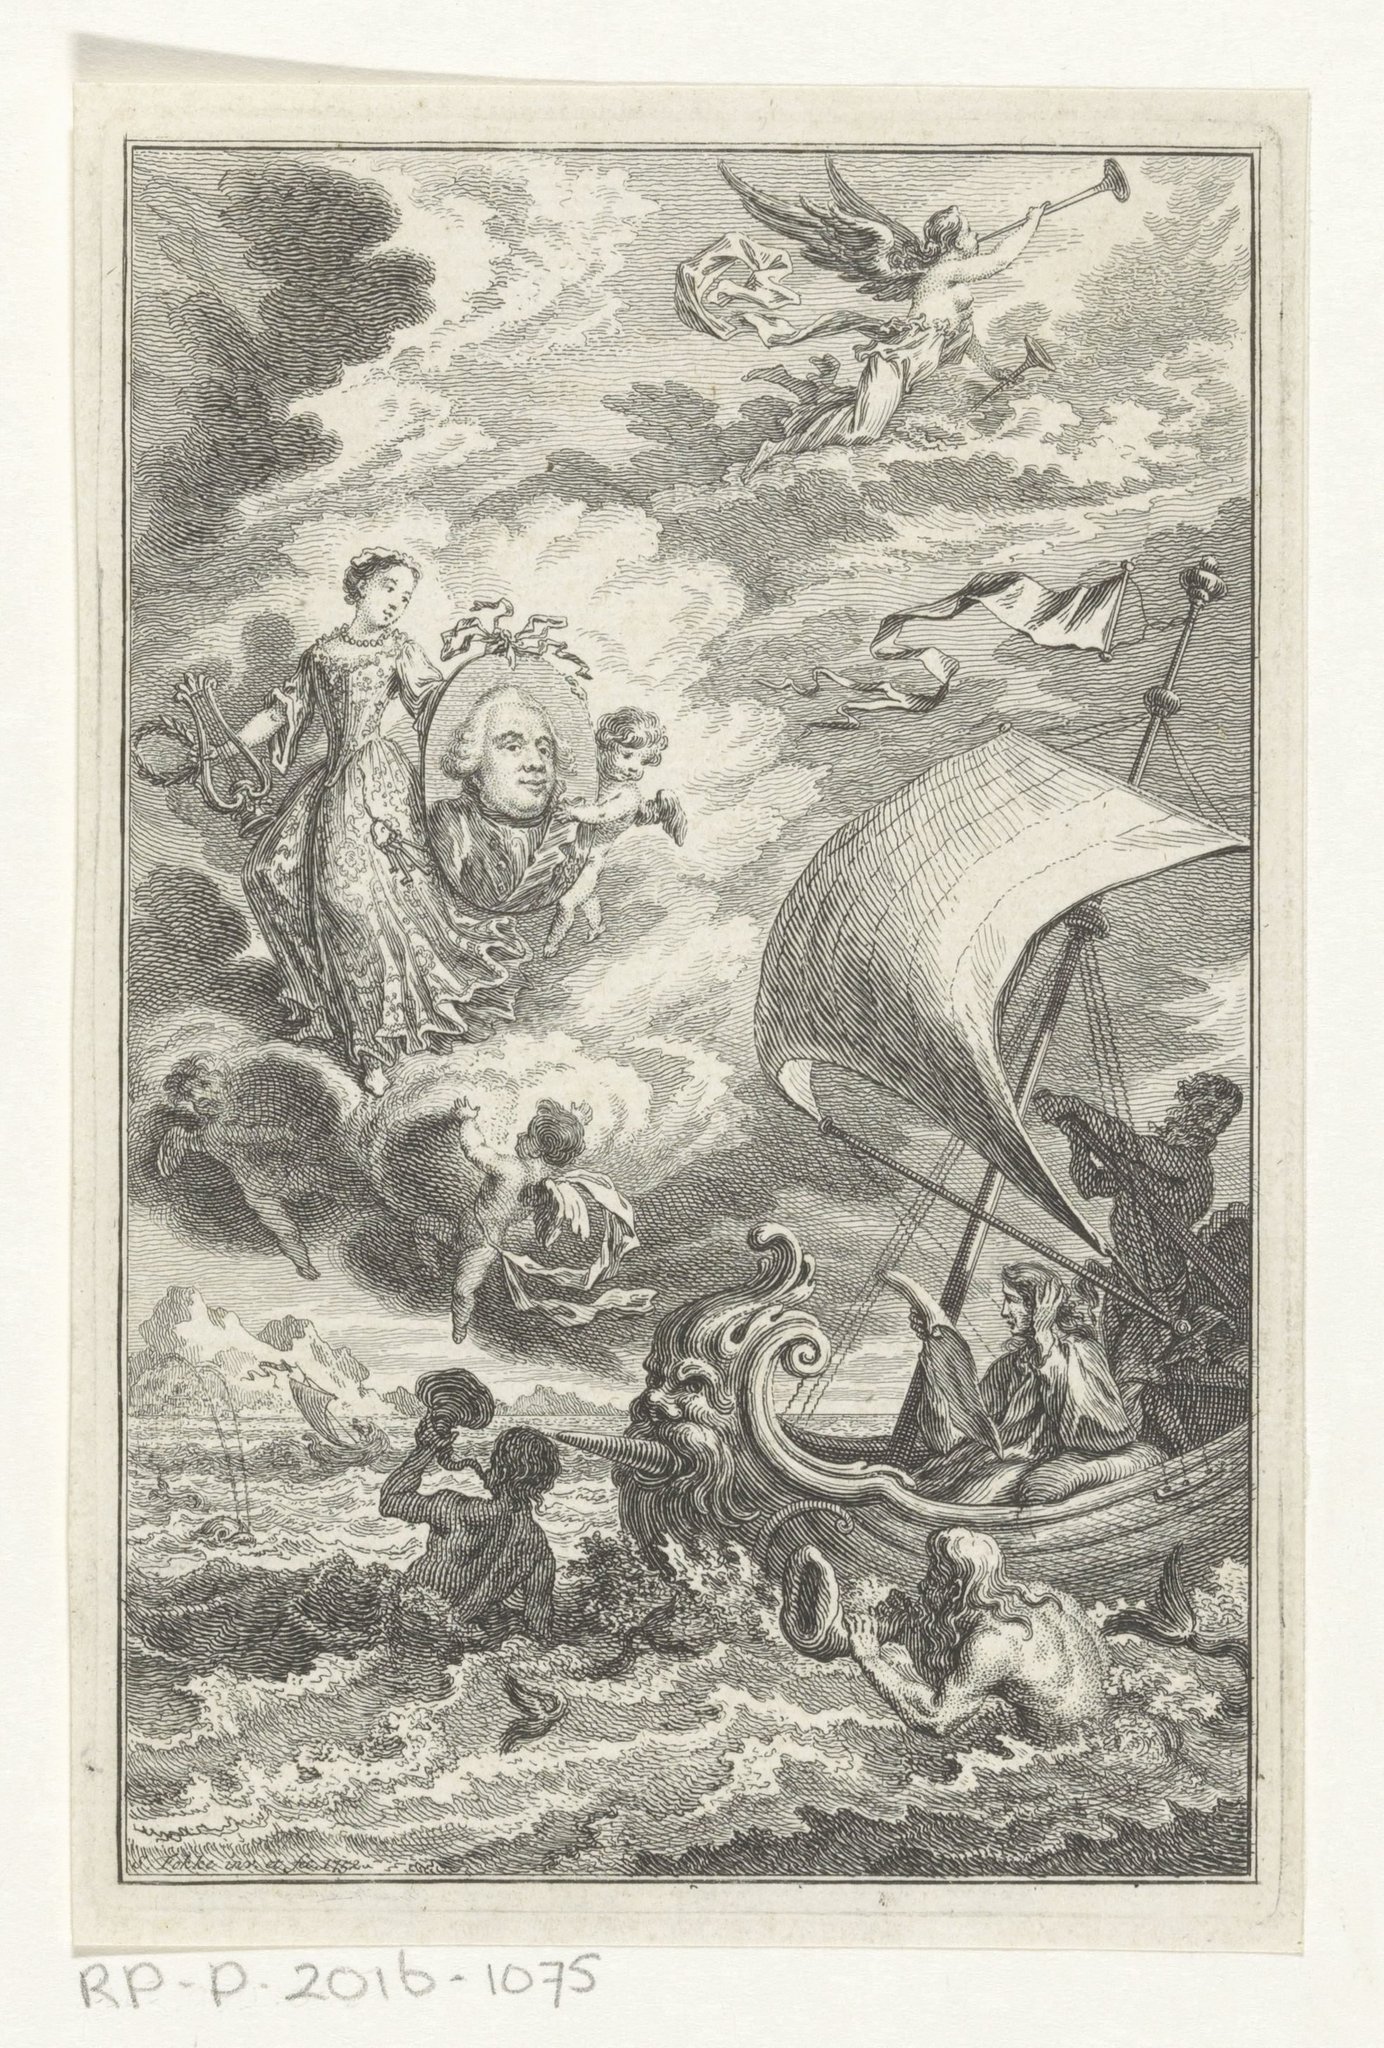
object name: print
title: Allegorische voorstelling met portret van Willem V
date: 1752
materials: paper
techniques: etching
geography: amsterdam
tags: william v (prince of orange), historical persons (+ historical person or scene in allegorical or symbolic frame or setting; or with allegorical or symbolic accessories), fame; 'fama', 'fama buona', 'fama chiara' (ripa)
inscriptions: collector's mark: Lugt 2228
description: In een boot, omringd door twee zeegoden, zit een gelauwerde man met een blad papier in zijn hand. In de lucht houdt een vrouw een lier en lauwerkrans vast en draagt samen met een putto het portret van Willem V in ovaal. Hoog in de lucht Fama met twee bazuinen.